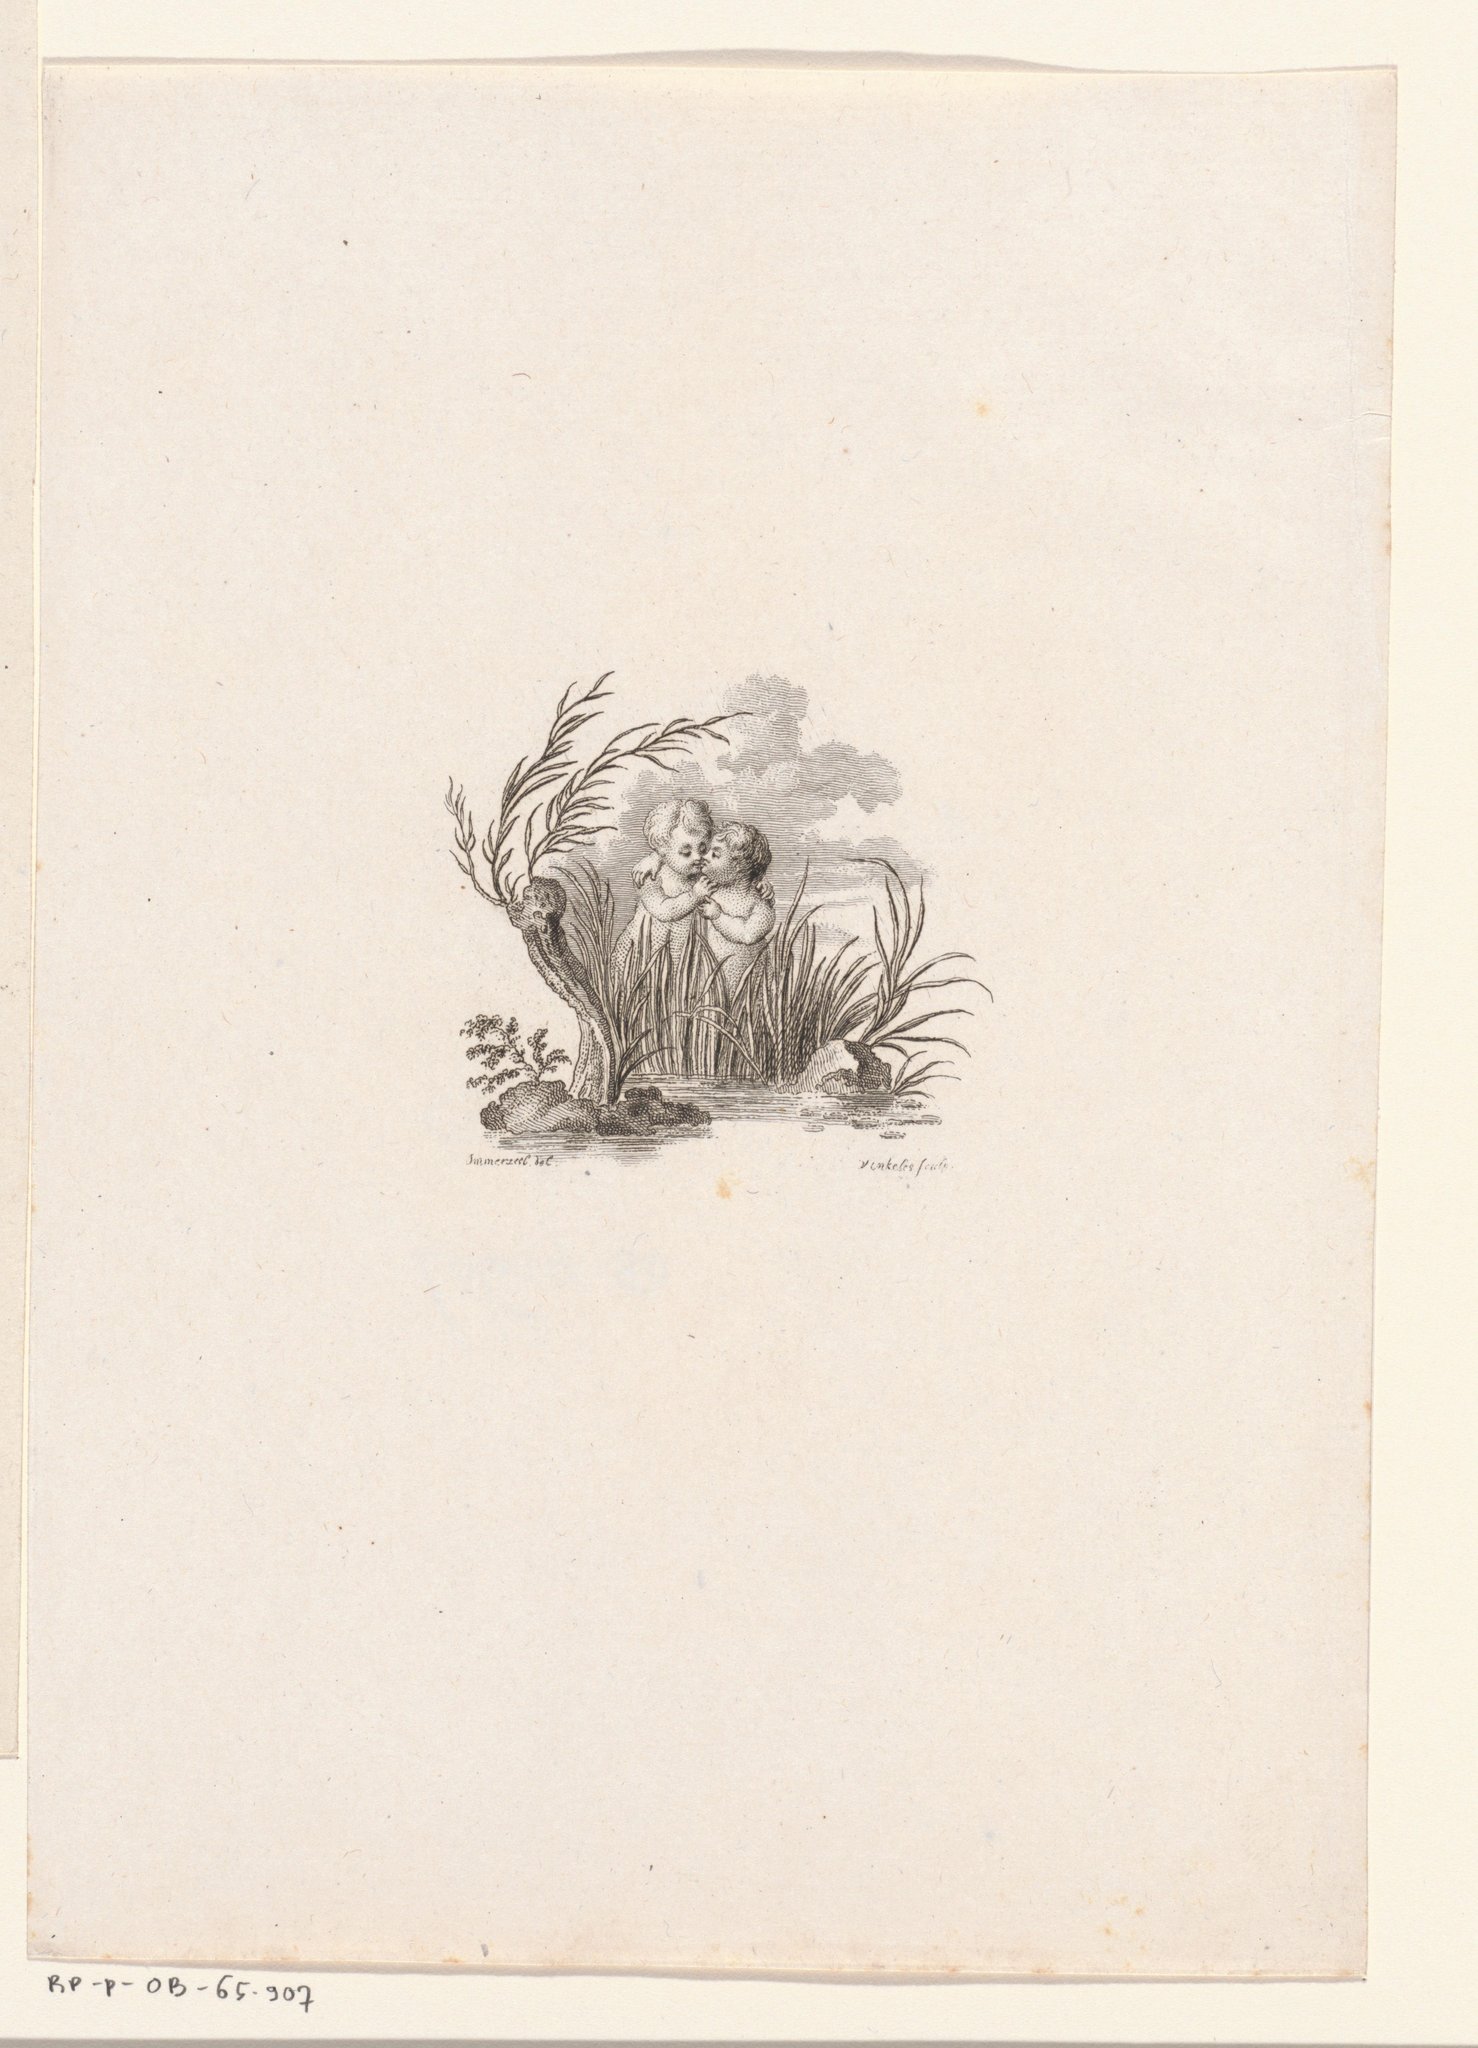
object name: print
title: Twee putti in een omhelzing in het riet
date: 1751-1816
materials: paper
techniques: etching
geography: amsterdam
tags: plants and herbs: reed, cupids: 'amores', 'amoretti', 'putti'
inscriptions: collector's mark: Lugt 2228